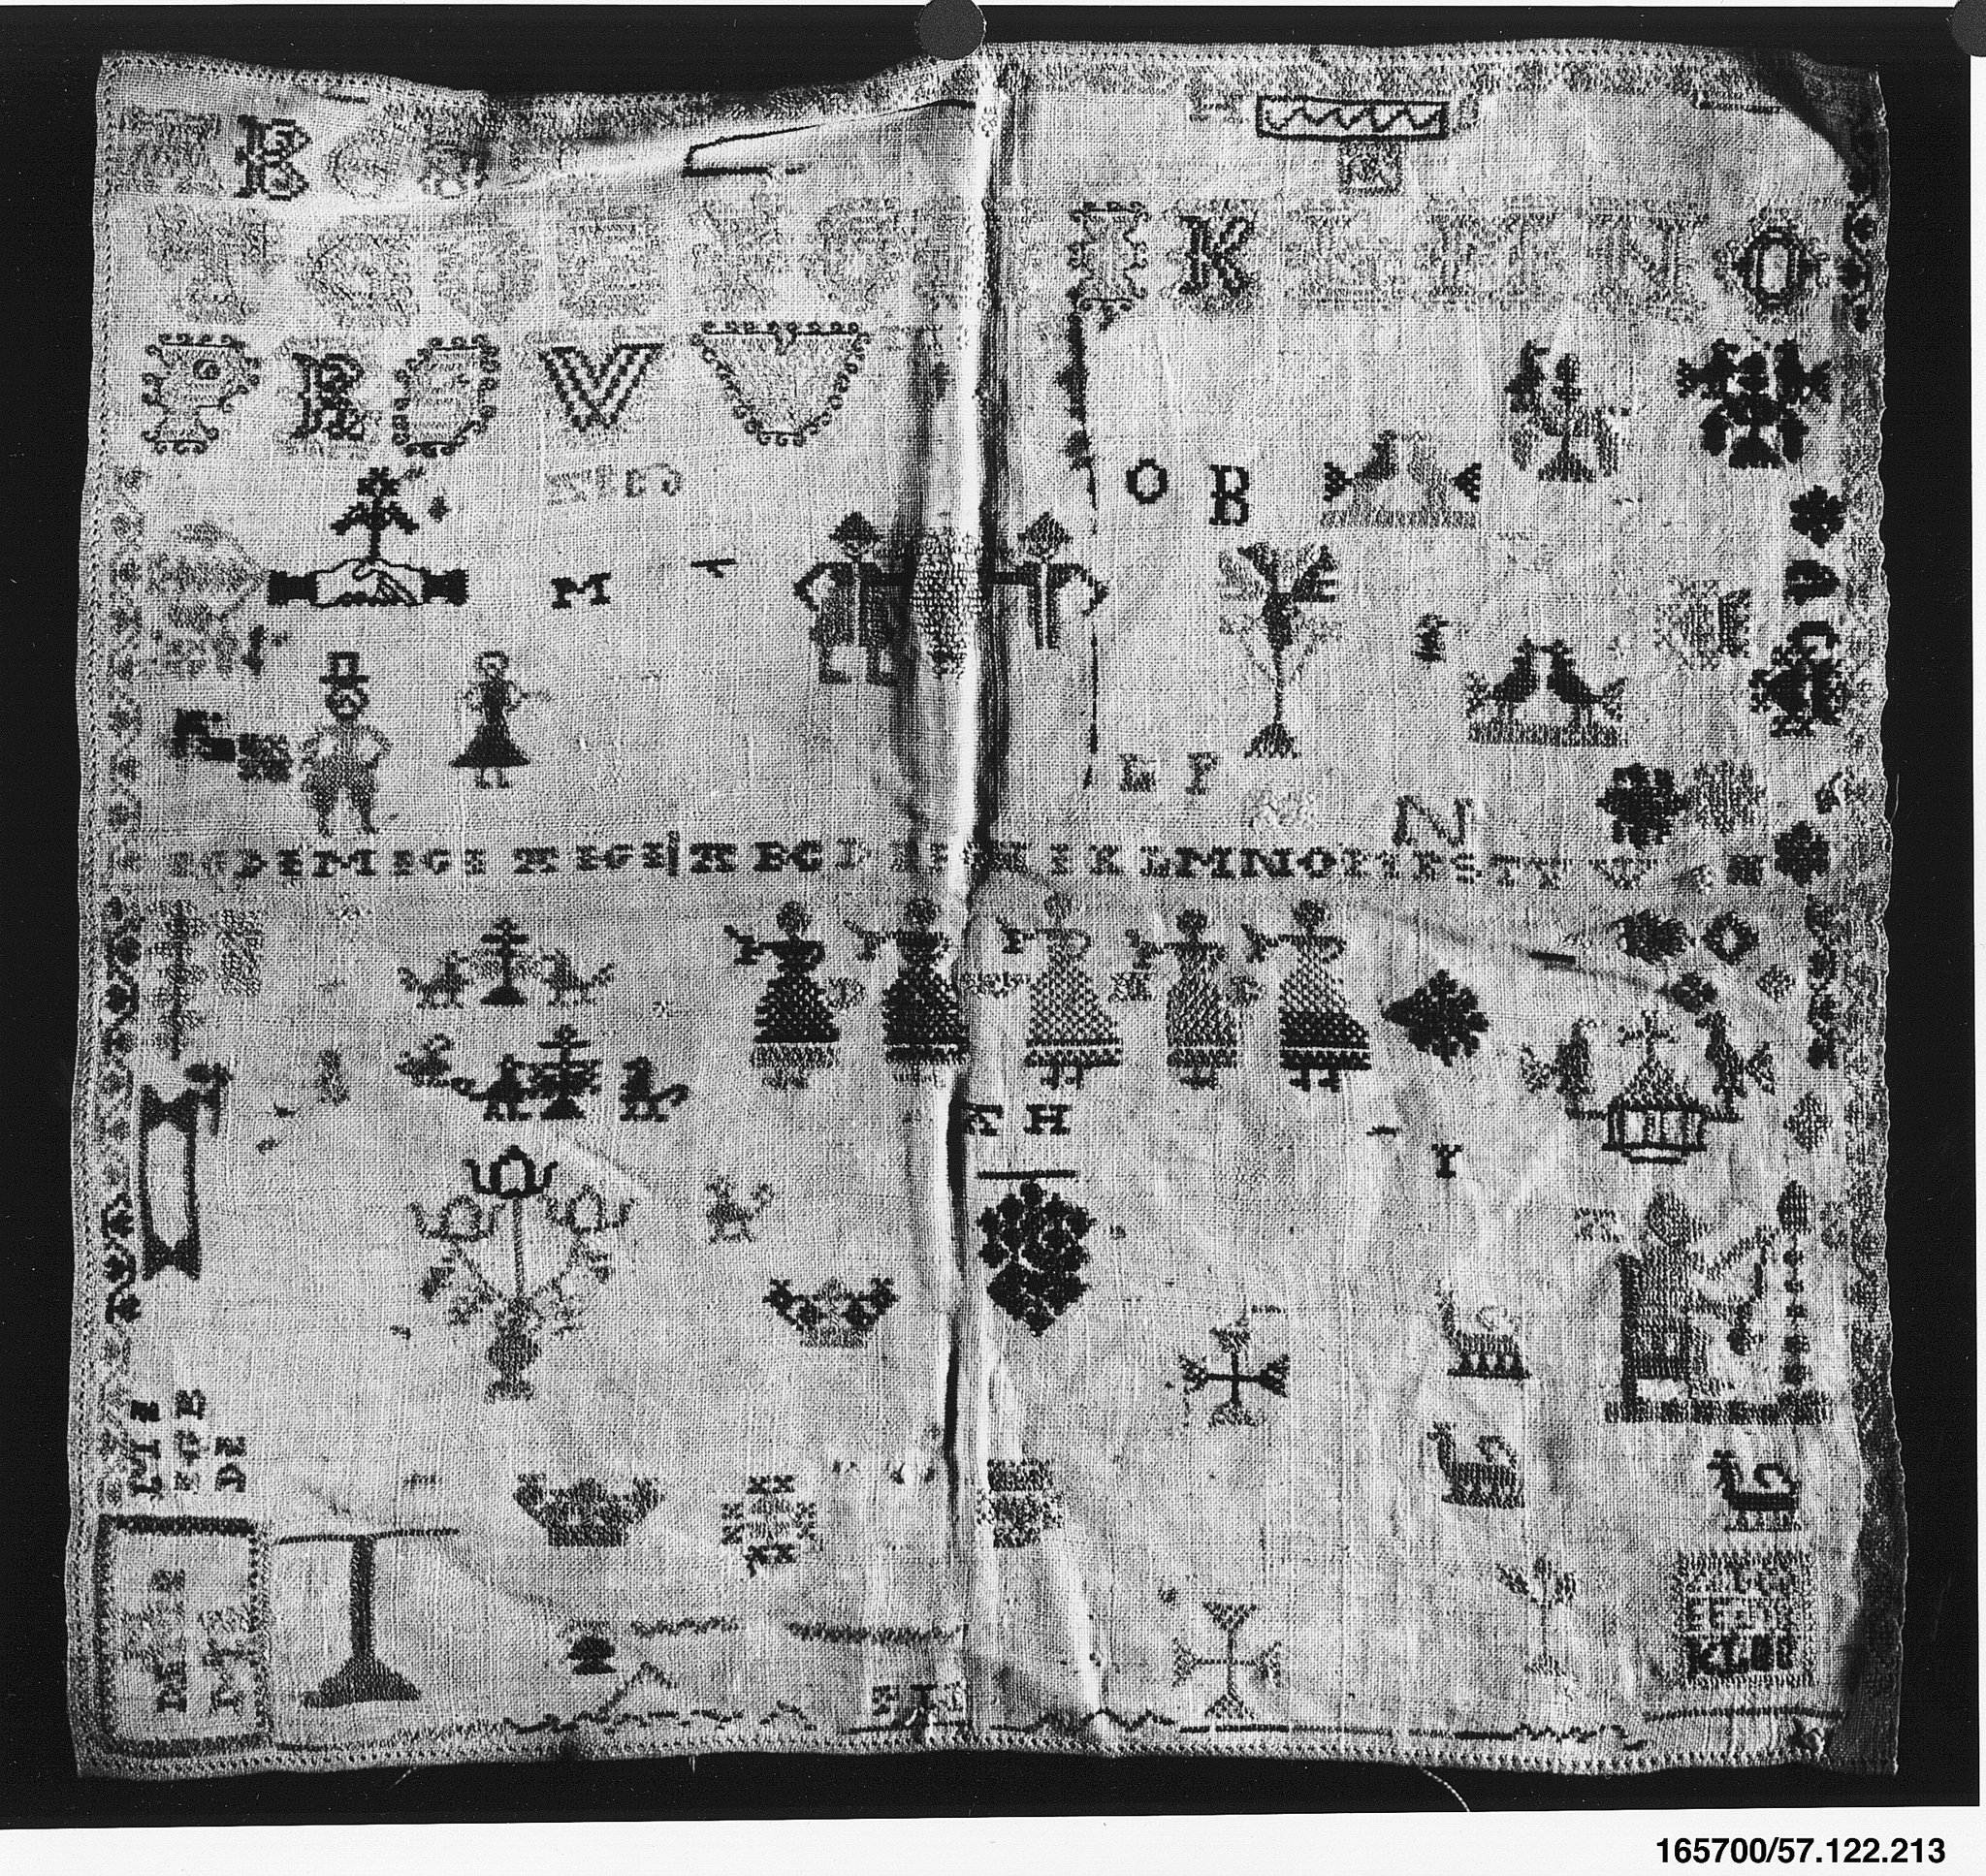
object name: sampler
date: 1701-1800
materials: linen, silk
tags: human figures,animals,birds